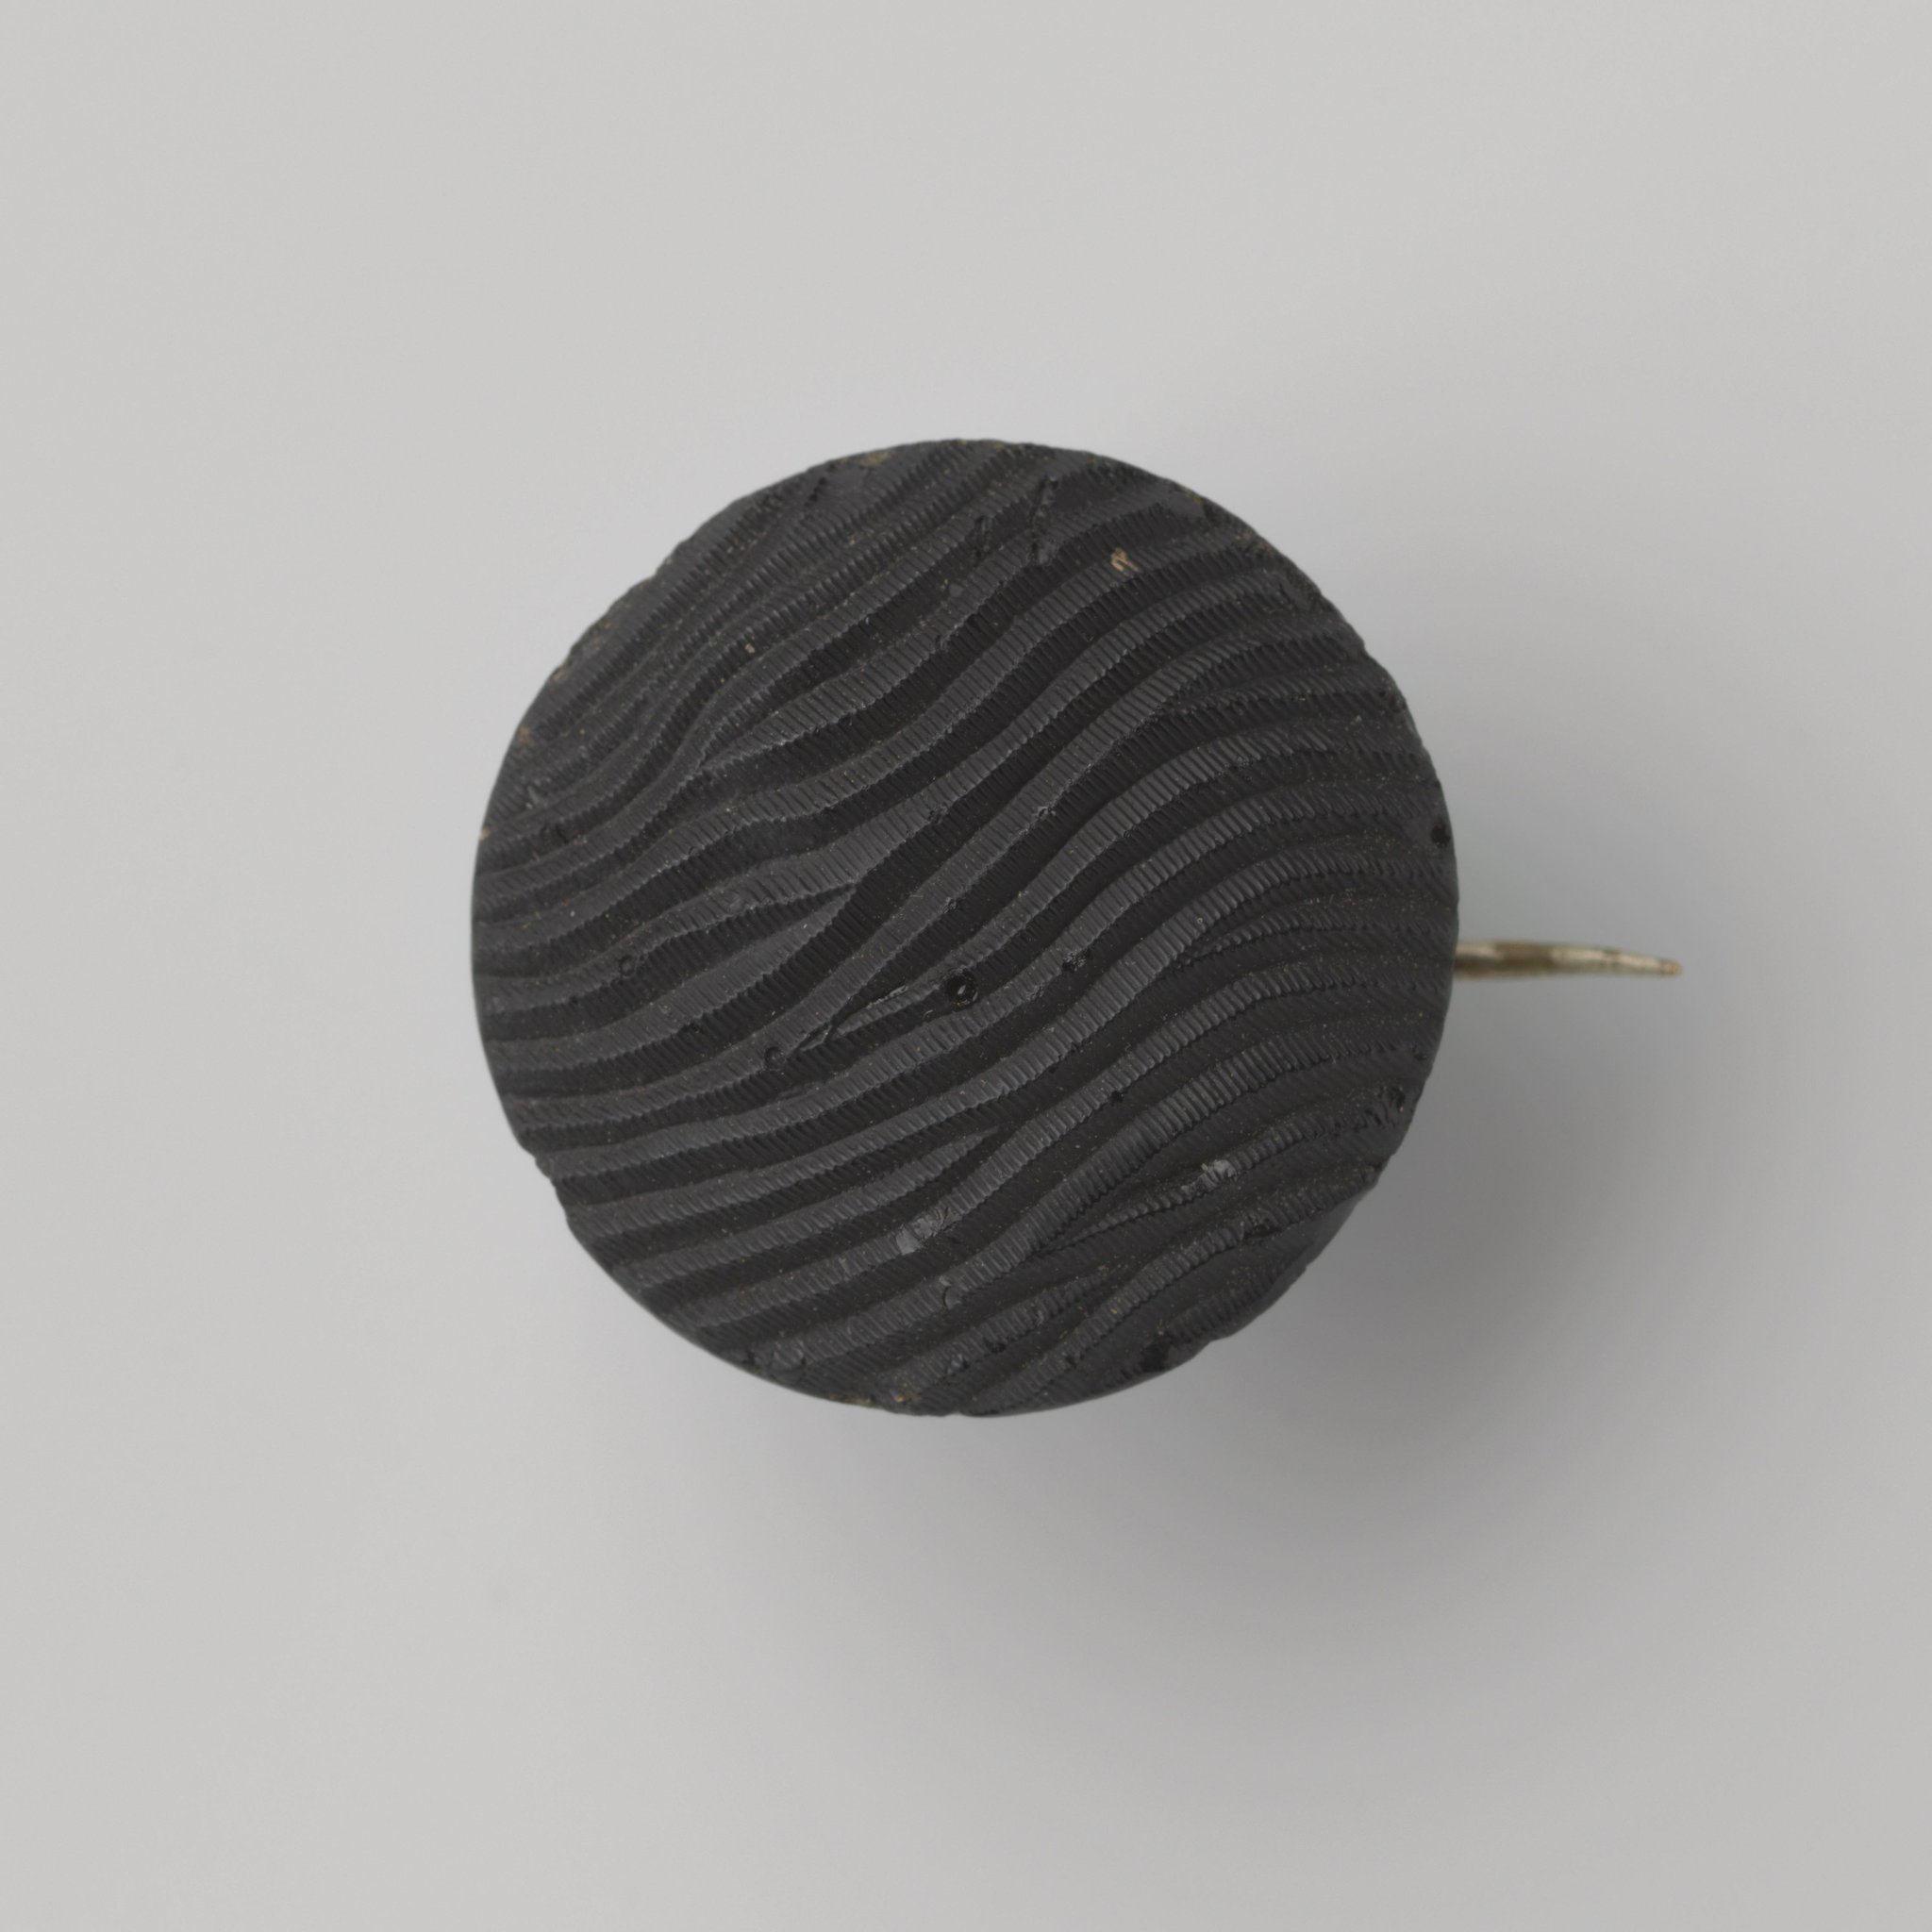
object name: brooch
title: Ronde geribde rouwbroche van glas en onedel metaal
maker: Anonymous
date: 1880-1900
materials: glass, metal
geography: schoonhoven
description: Een rond licht bollend zwart stuk glas met golven in reliëf is gezet op een ronde zilverkleurige brochering met een haaksluiting.